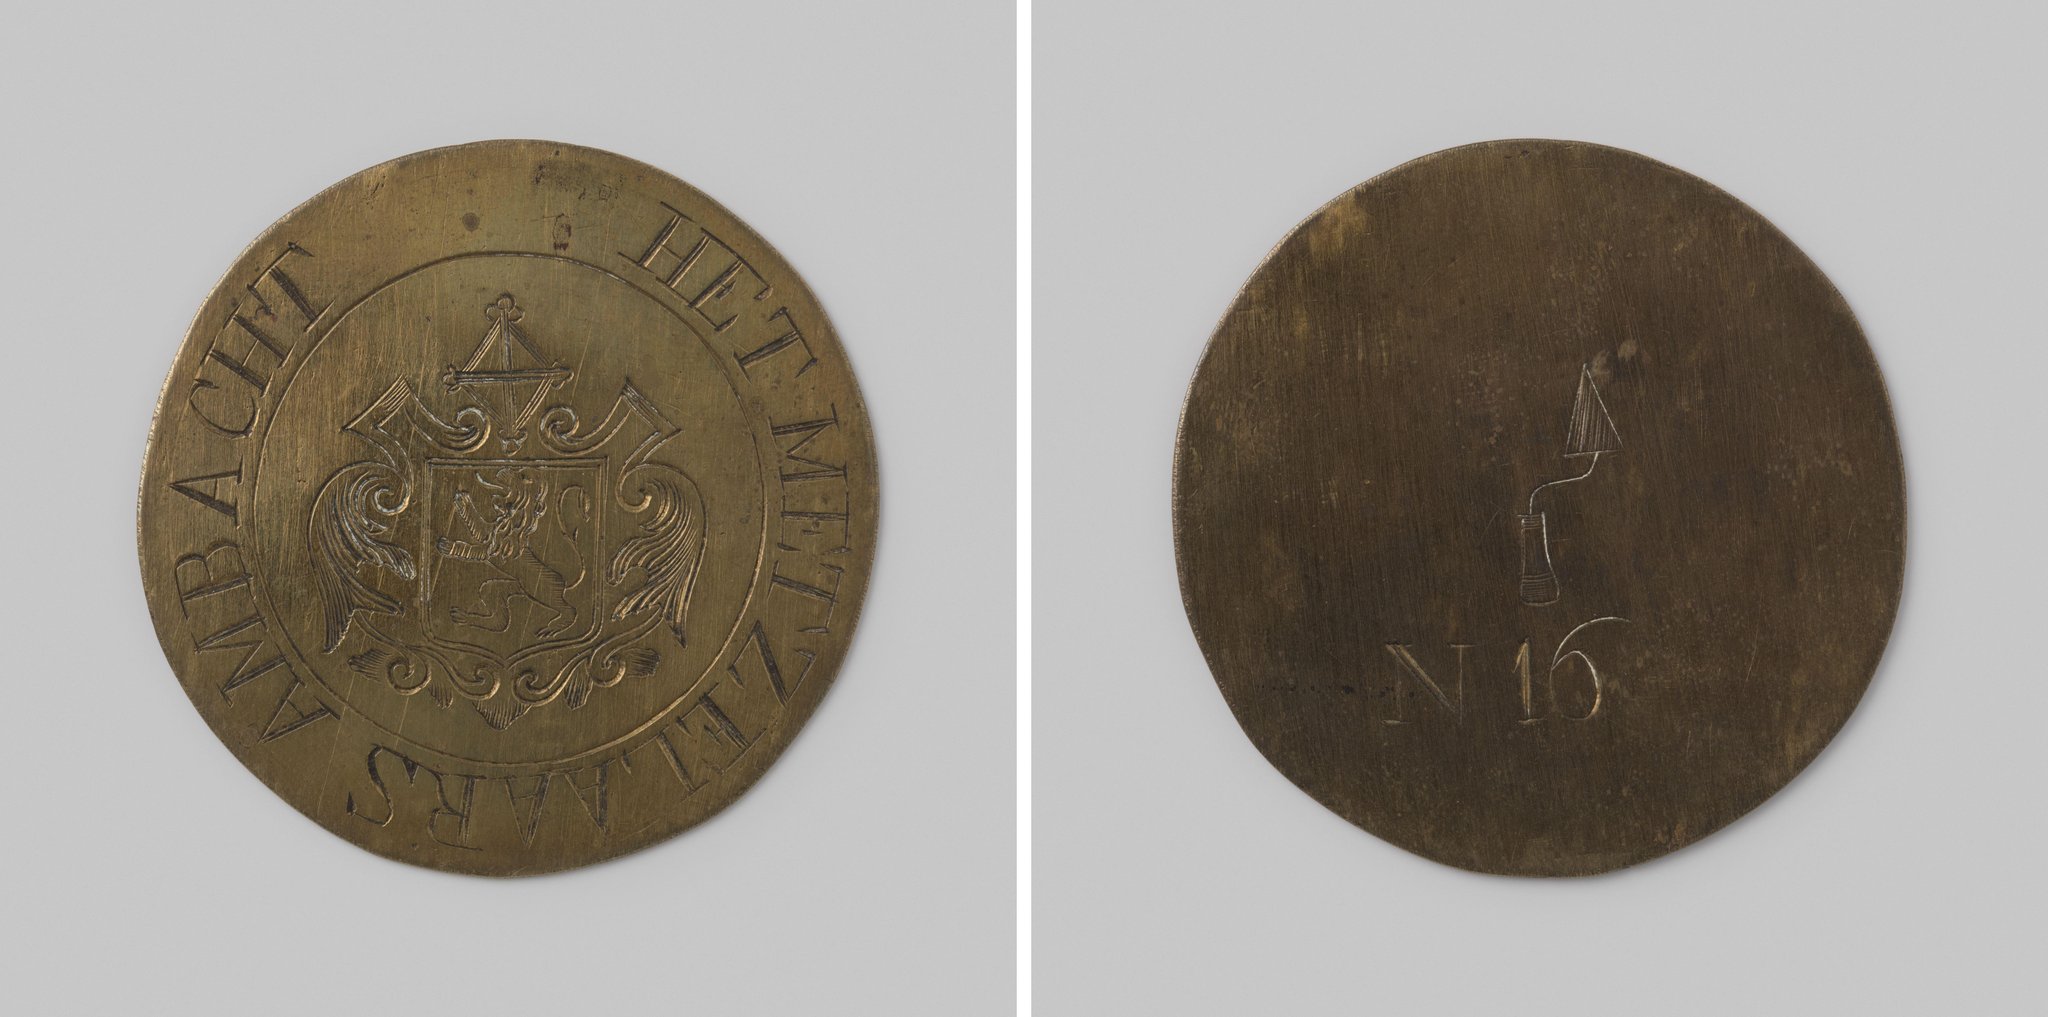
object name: medal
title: Presentiepenning van het Metselaarsgilde te Zierikzee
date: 1600-1800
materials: brass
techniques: engraving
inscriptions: inscription: ‘N 16’, circumscription: ‘HET METZELAARS AMBACHT’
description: Fors rond messing plaatje gegraveerd op de voorzijde een versierd wapenschild Zierikzee met omschrift, op de keerzijde een troffel en de tekst N 16